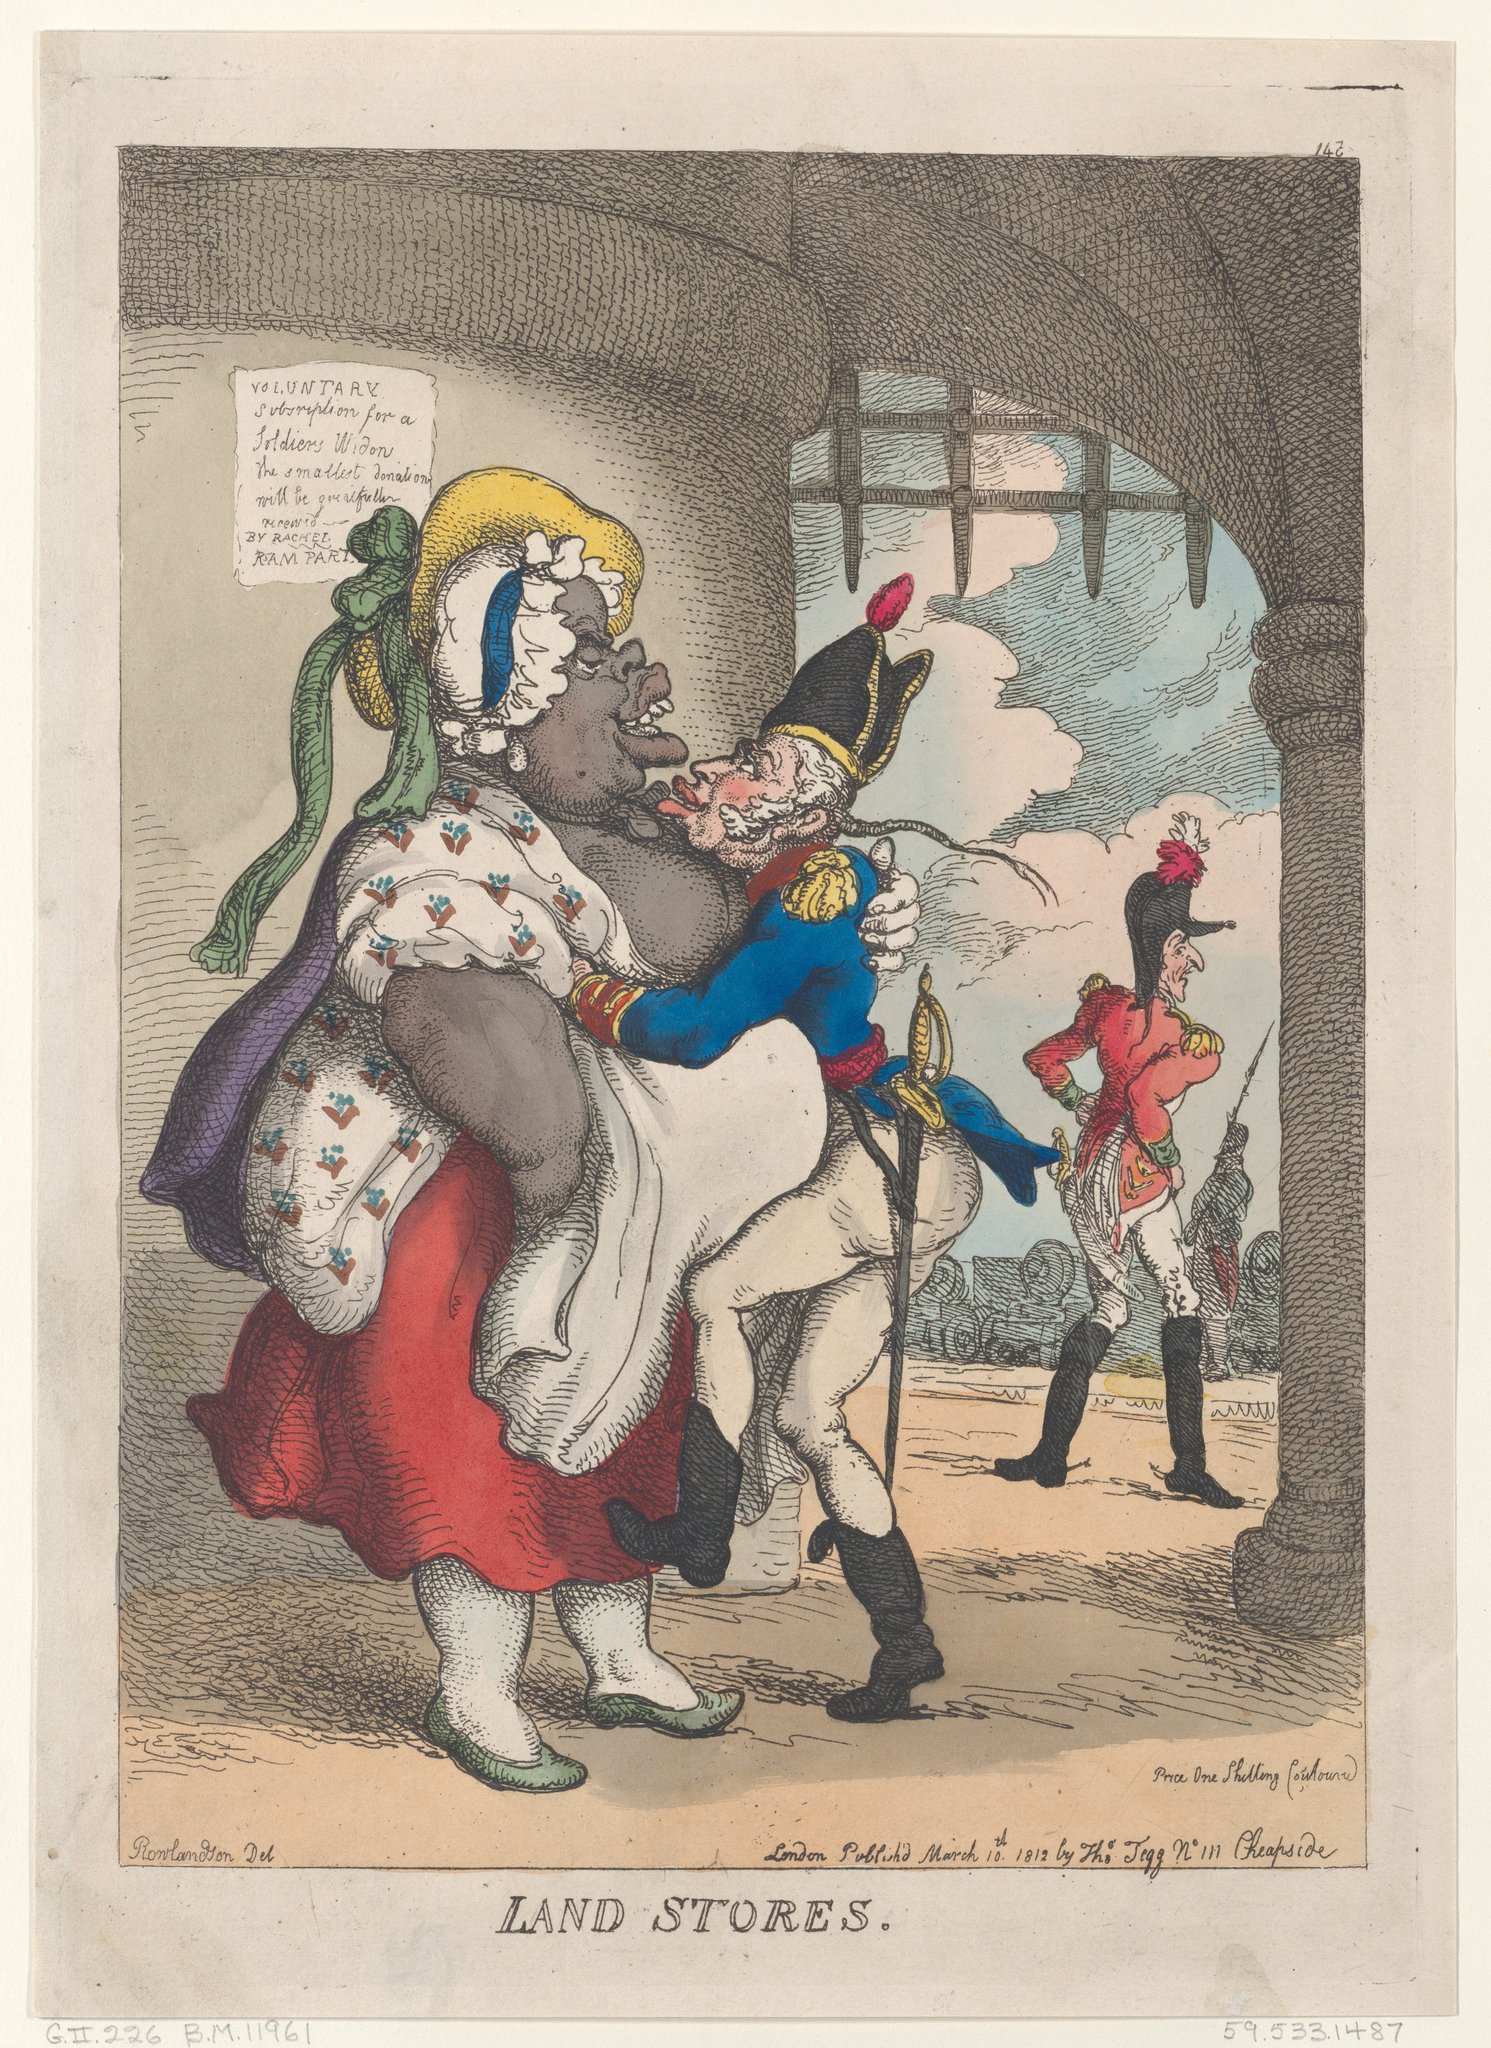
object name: print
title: Land Stores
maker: thomas rowlandson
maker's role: artist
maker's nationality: british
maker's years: 1757-1827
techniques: etching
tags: satire,soldiers,men,women